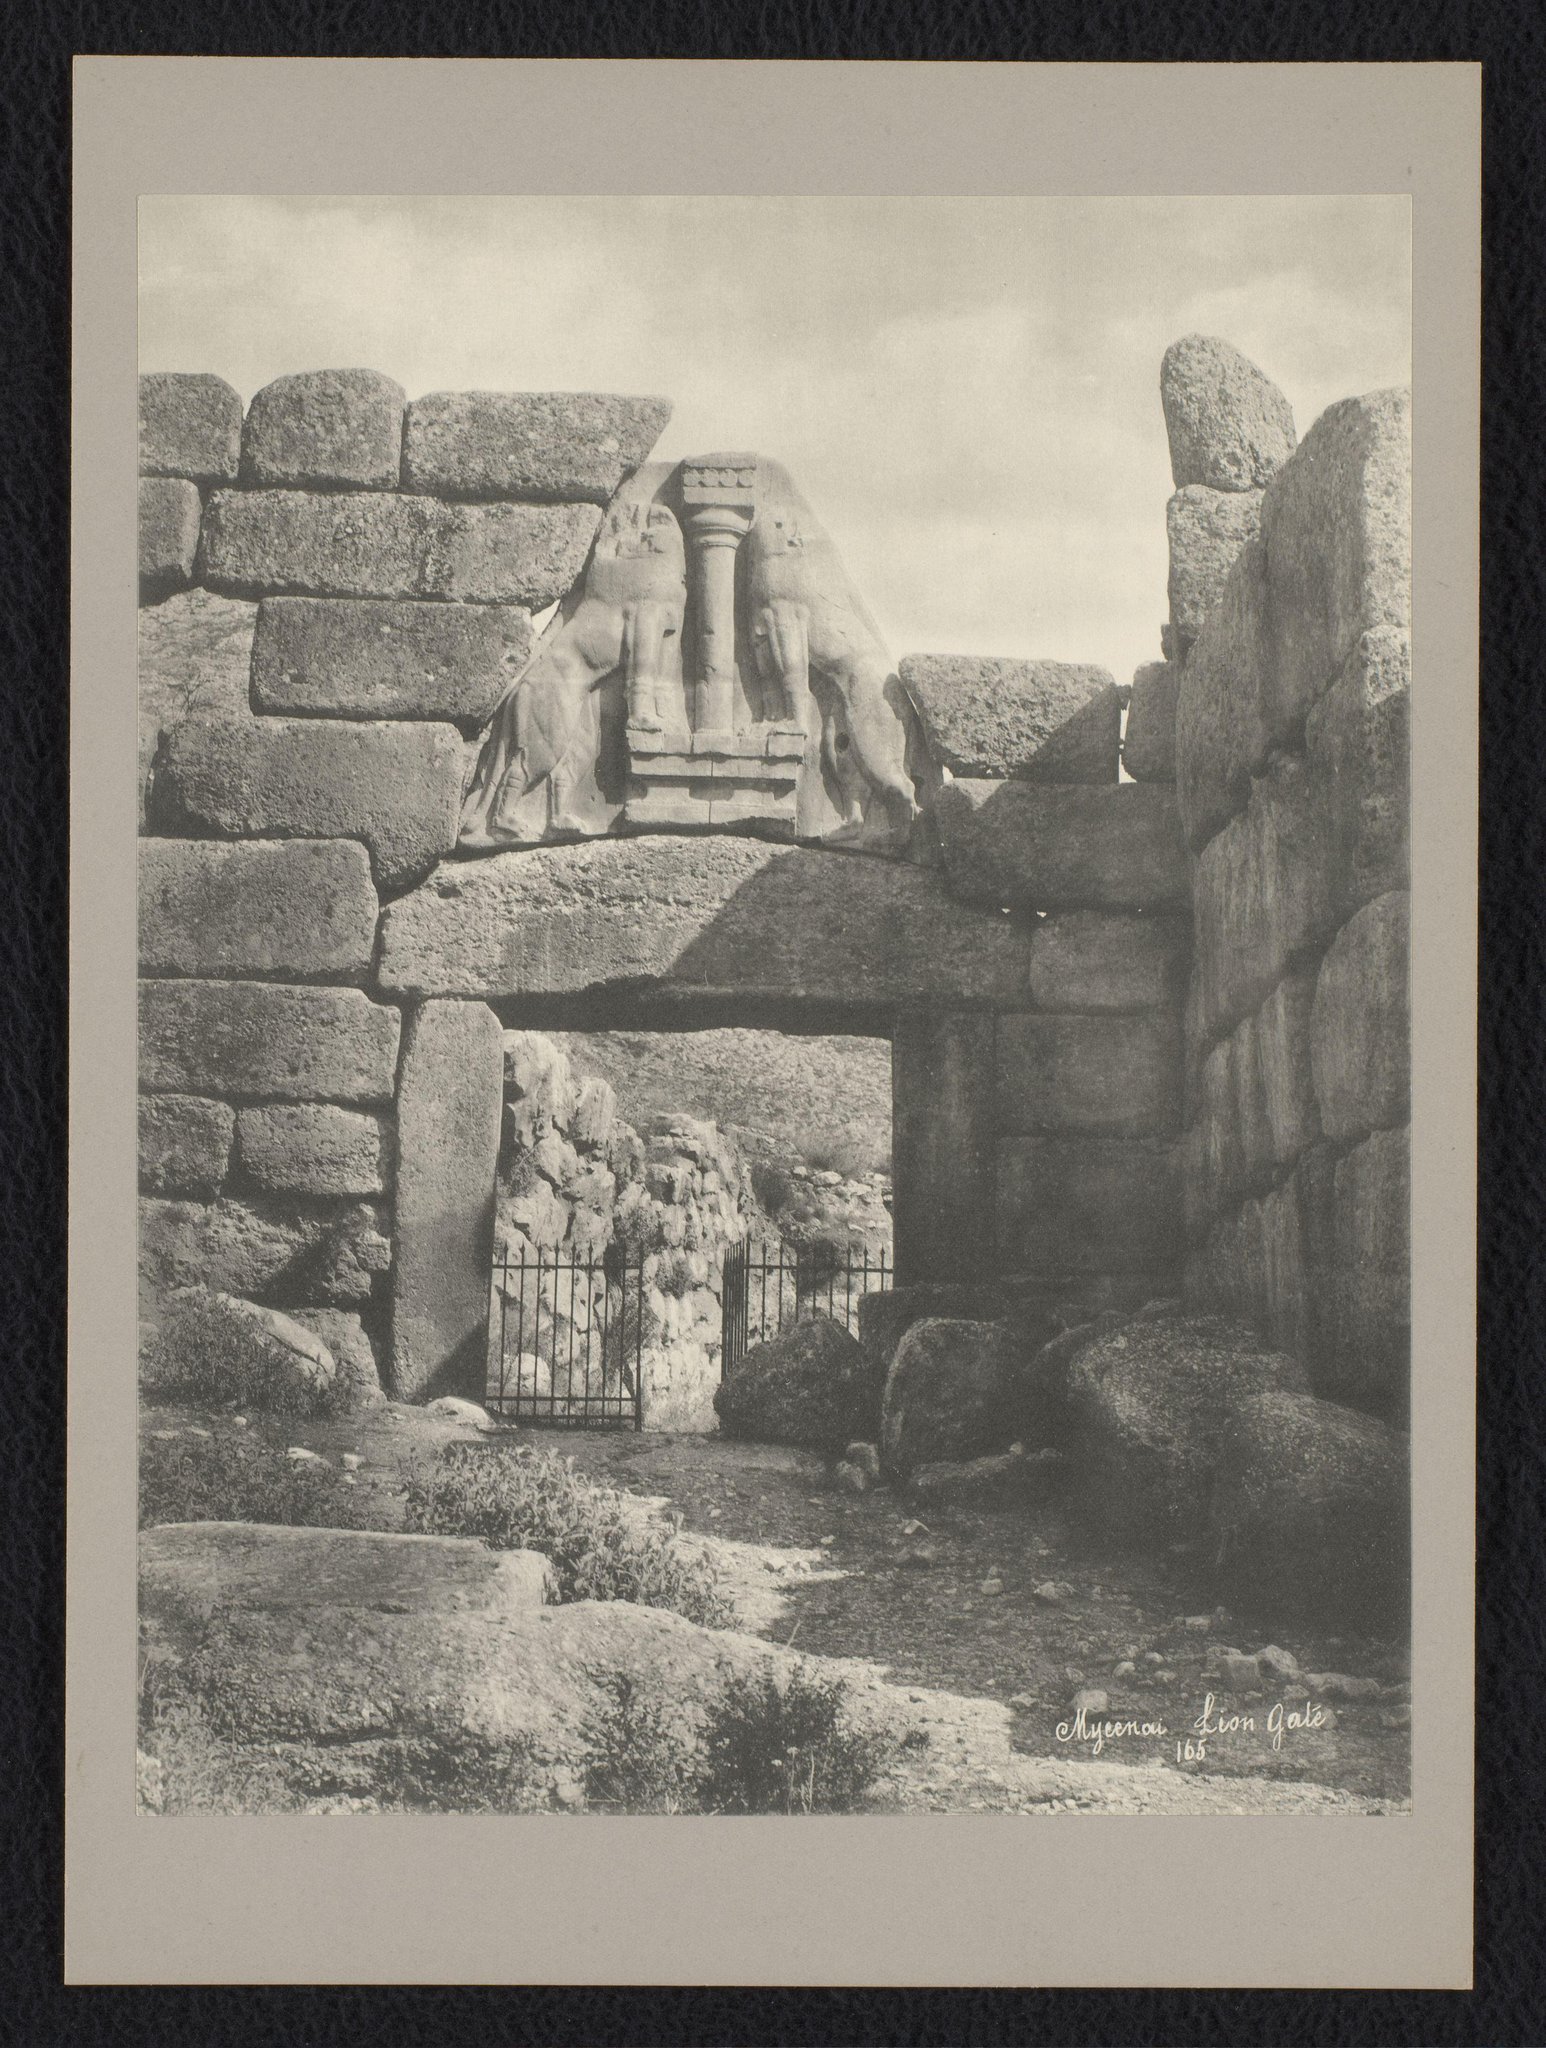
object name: photograph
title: Mycenai Lion Gate 165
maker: Anonymous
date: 1895-1915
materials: cardboard, paper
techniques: photograph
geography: mycene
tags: mycene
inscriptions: number: ‘11.’